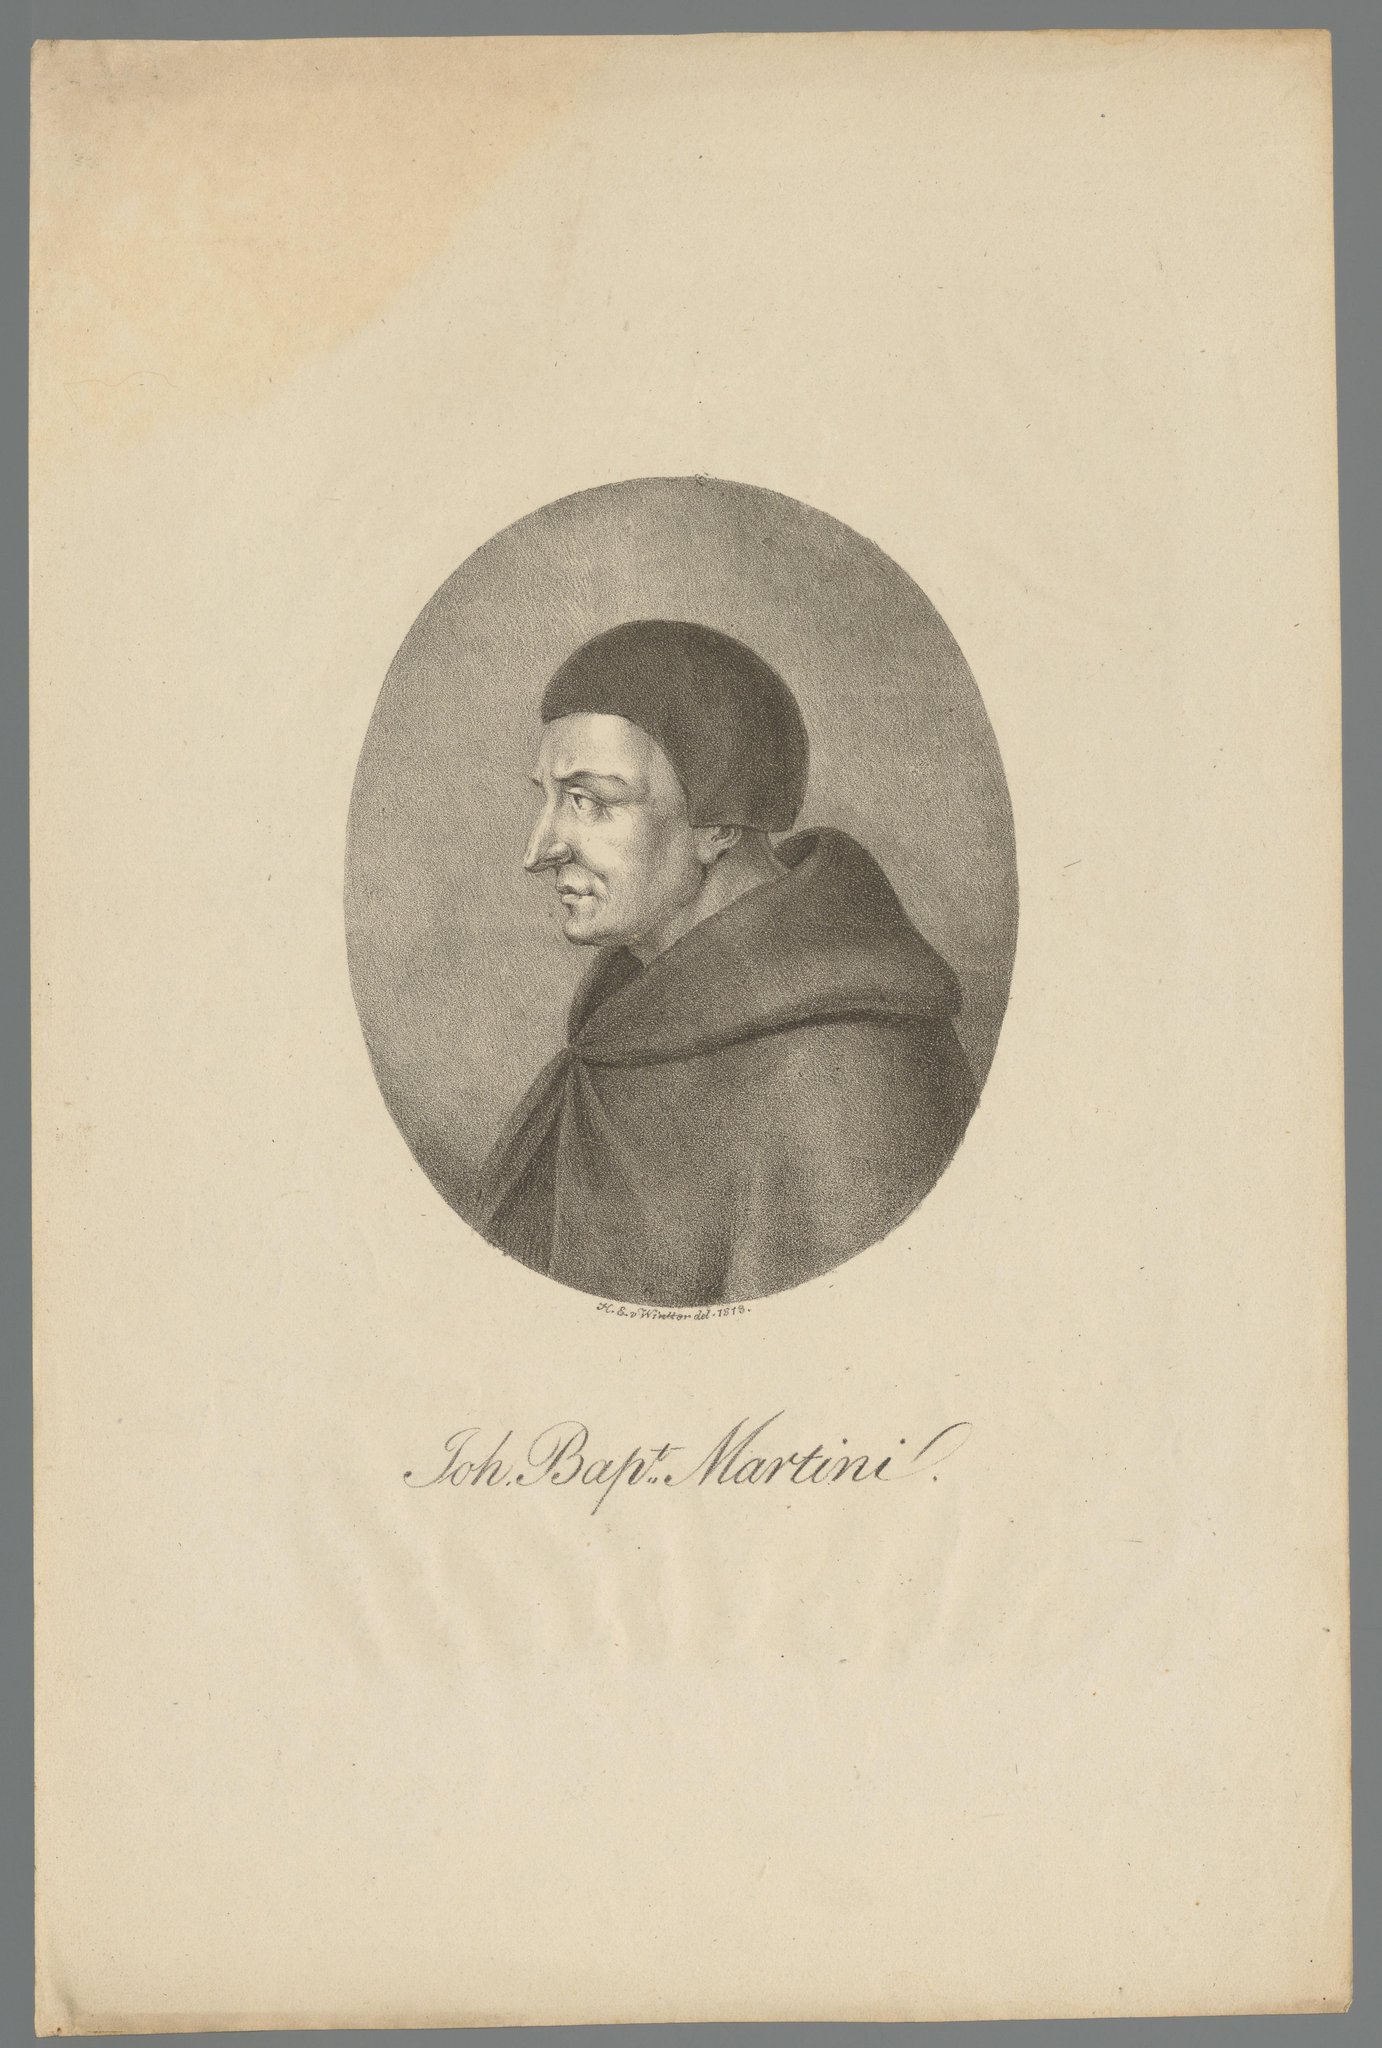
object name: print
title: Portret van Giovanni Battista Martini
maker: heinrich e. von winter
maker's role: print maker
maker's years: 1788-1825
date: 1813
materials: paper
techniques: lithograph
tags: head-gear, adult man, historical persons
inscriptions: watermark: ‘M. Heusler’, collector's mark: Lugt 2228